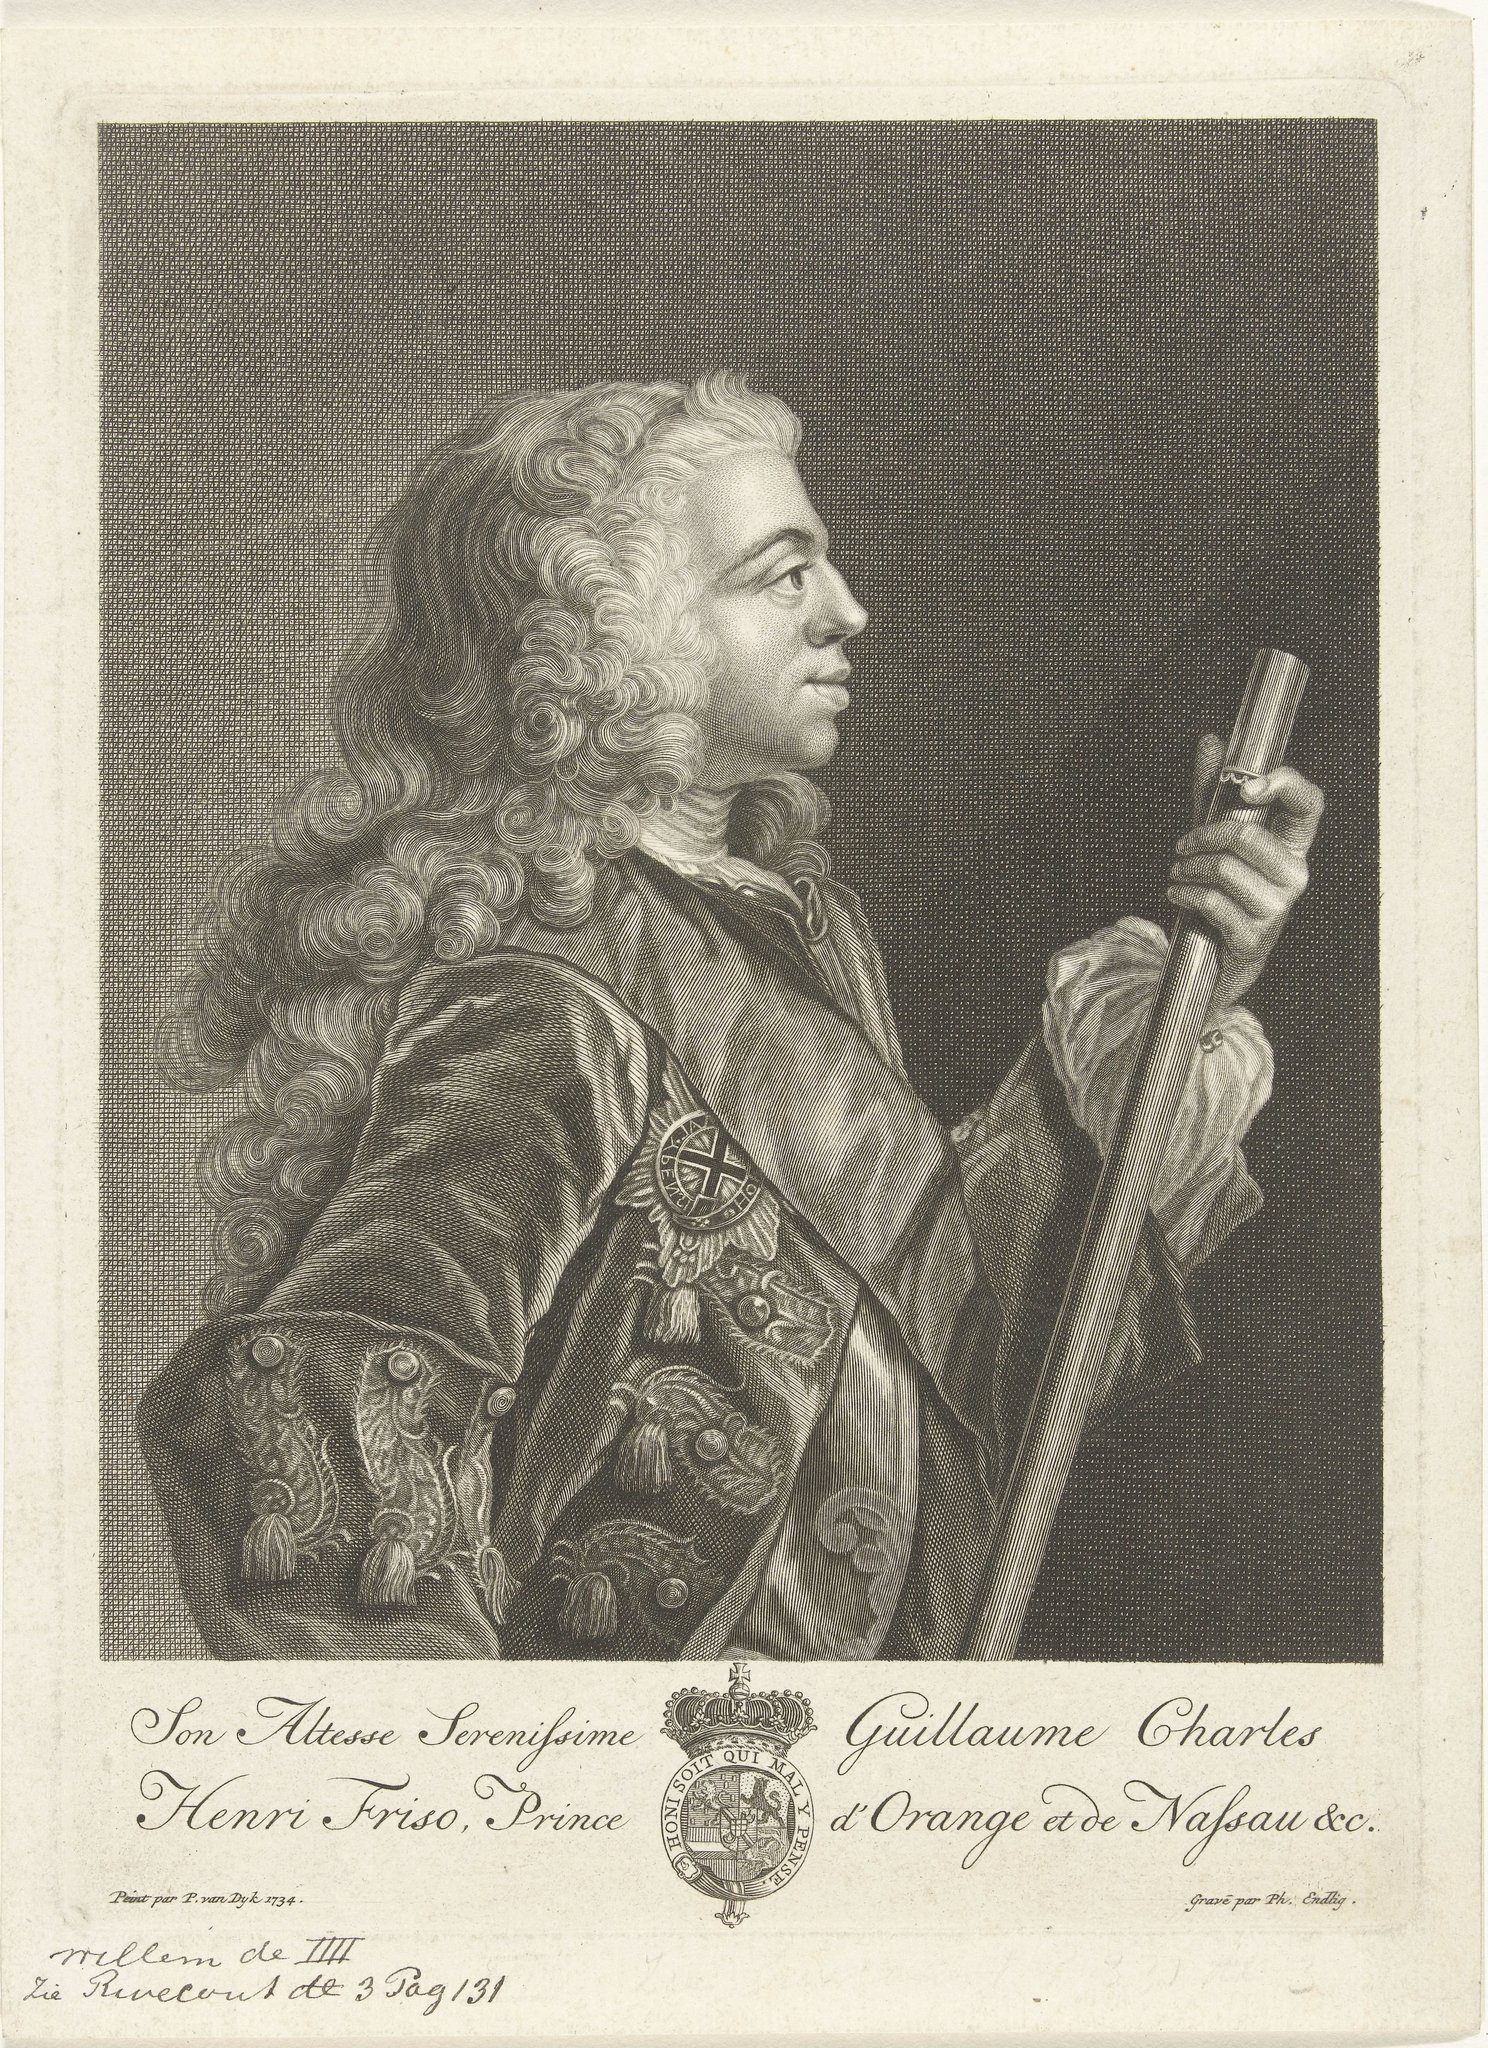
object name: print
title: Portret van Willem Karel Hendrik Friso van Oranje-Nassau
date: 1734-1747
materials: paper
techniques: engraving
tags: willem iv (prins van oranje-nassau), knighthood order (garter) - insignia of a knighthood order, e.g.: badge, chain, historical persons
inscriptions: collector's mark: Lugt 2228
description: Portret ten halven lijve van Willem Karel Hendrik Friso (Willem IV) van Oranje-Nassau. De prins is en profil afgebeeld met een commandostaf in de hand. Onder de voorstelling een wapen met aan weerszijden de titel van de prent.